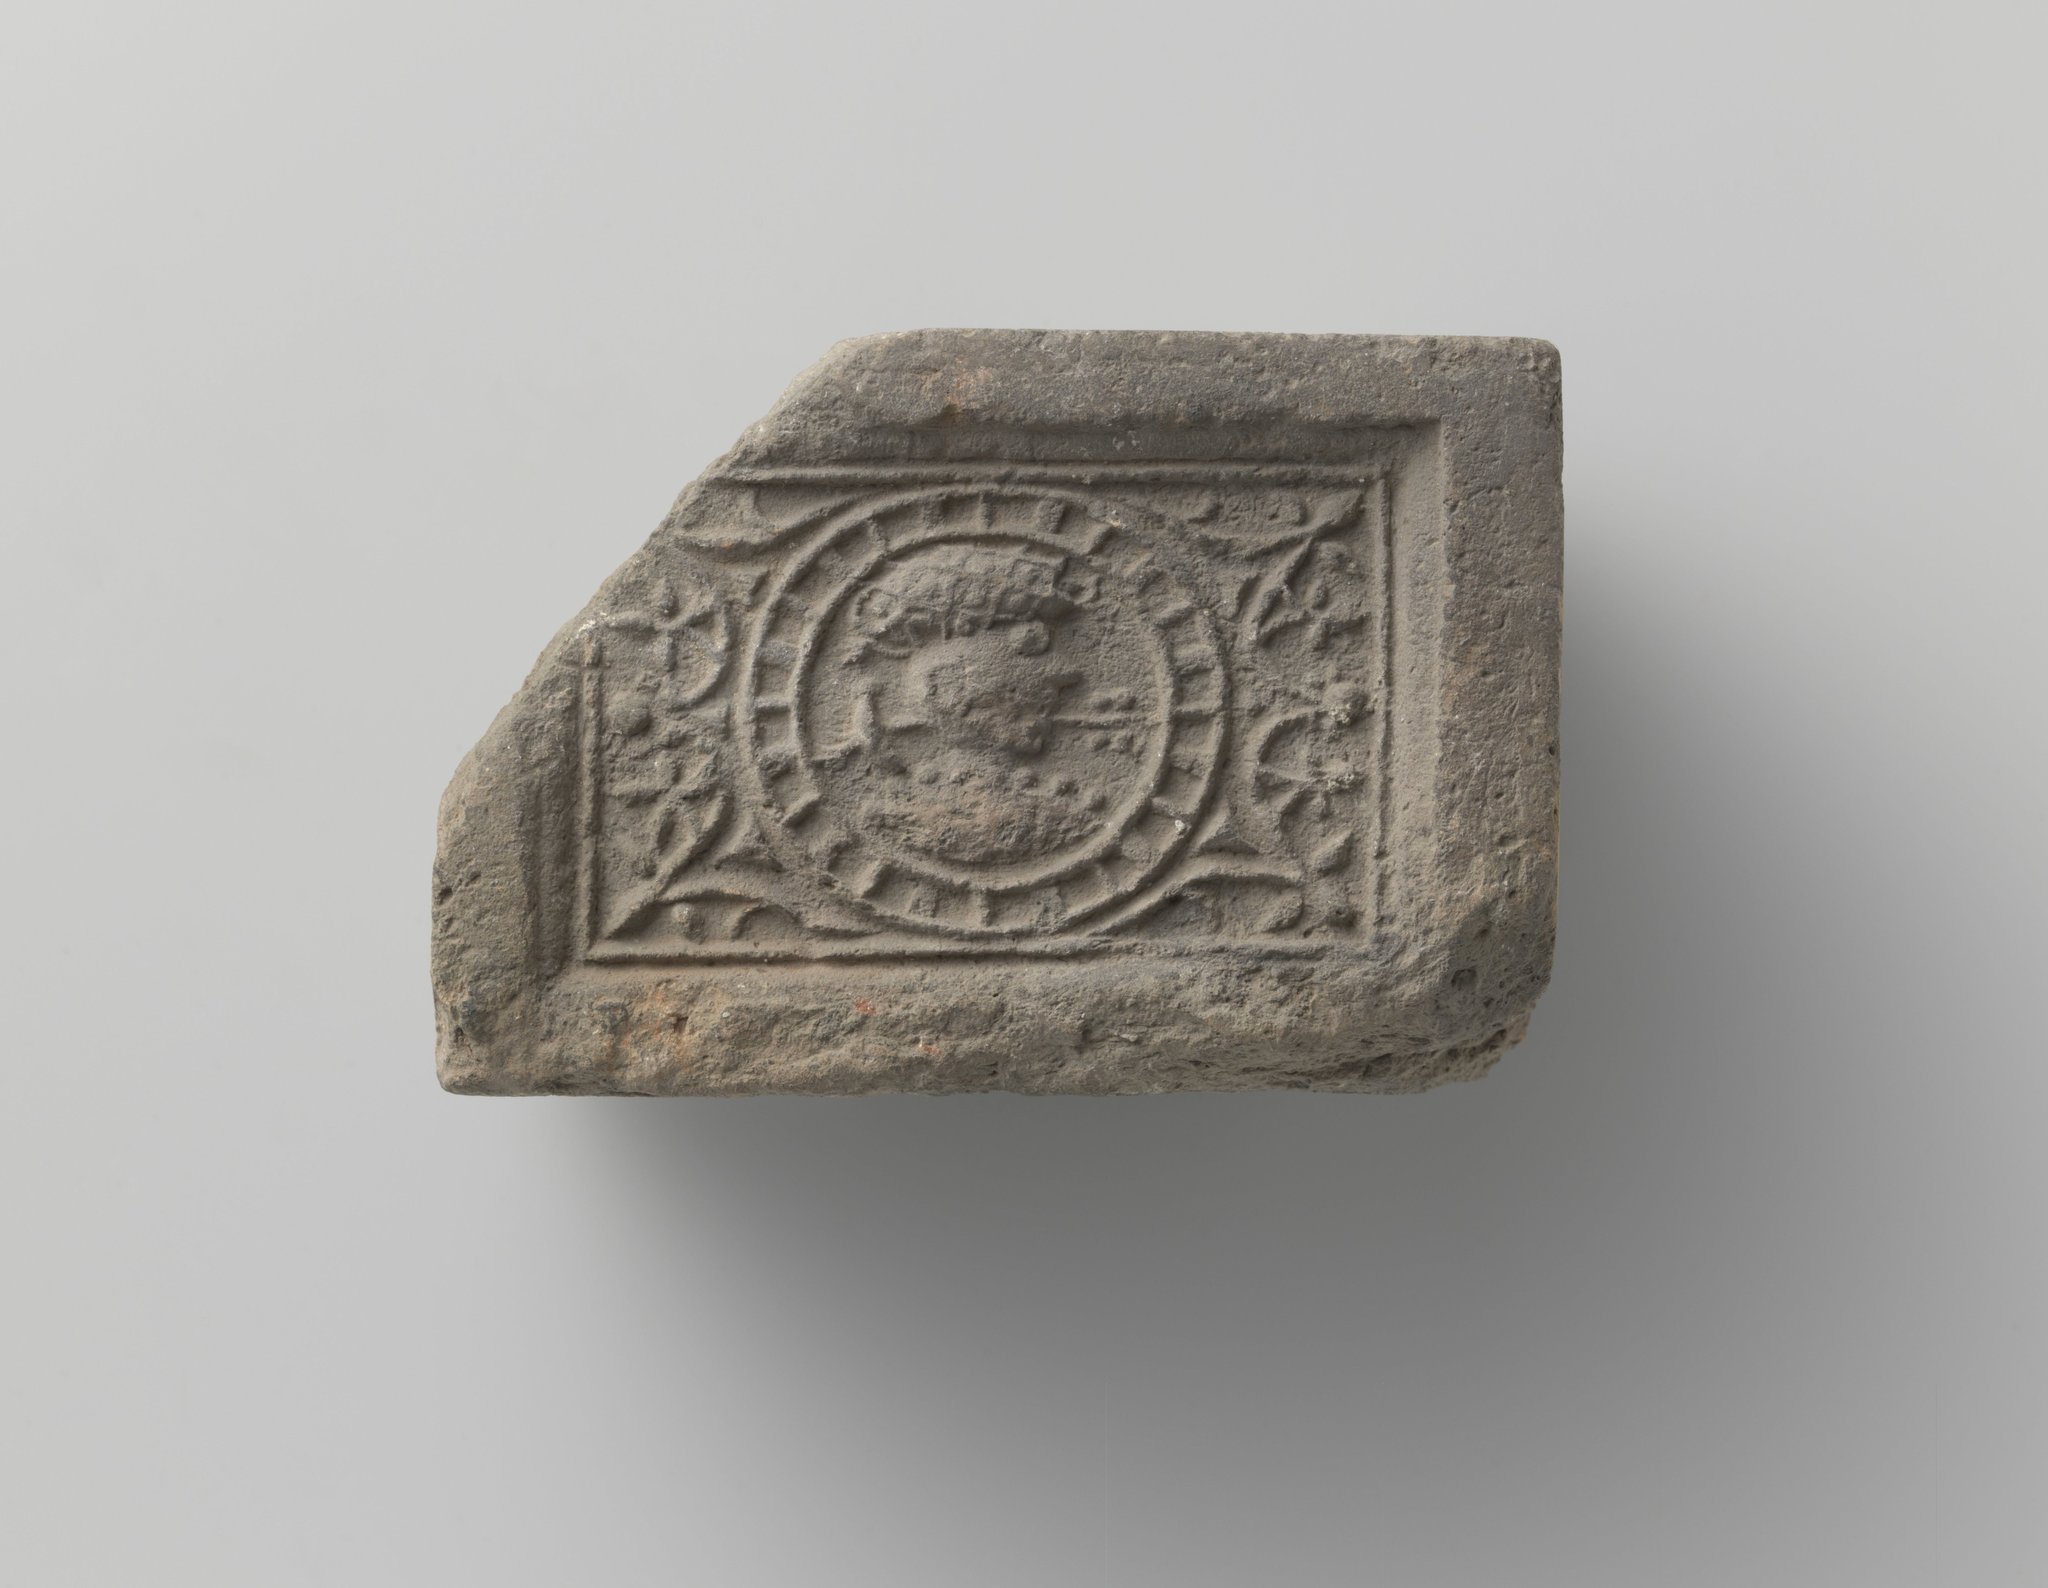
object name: architectural element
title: Haardsteen met afbeelding van een mannenkop van opzij, geplaatst in een rond medaillon.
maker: Anonymous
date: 1550-1575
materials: earthenware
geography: southern netherlands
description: Haardsteen met een mansportret en medaillon.